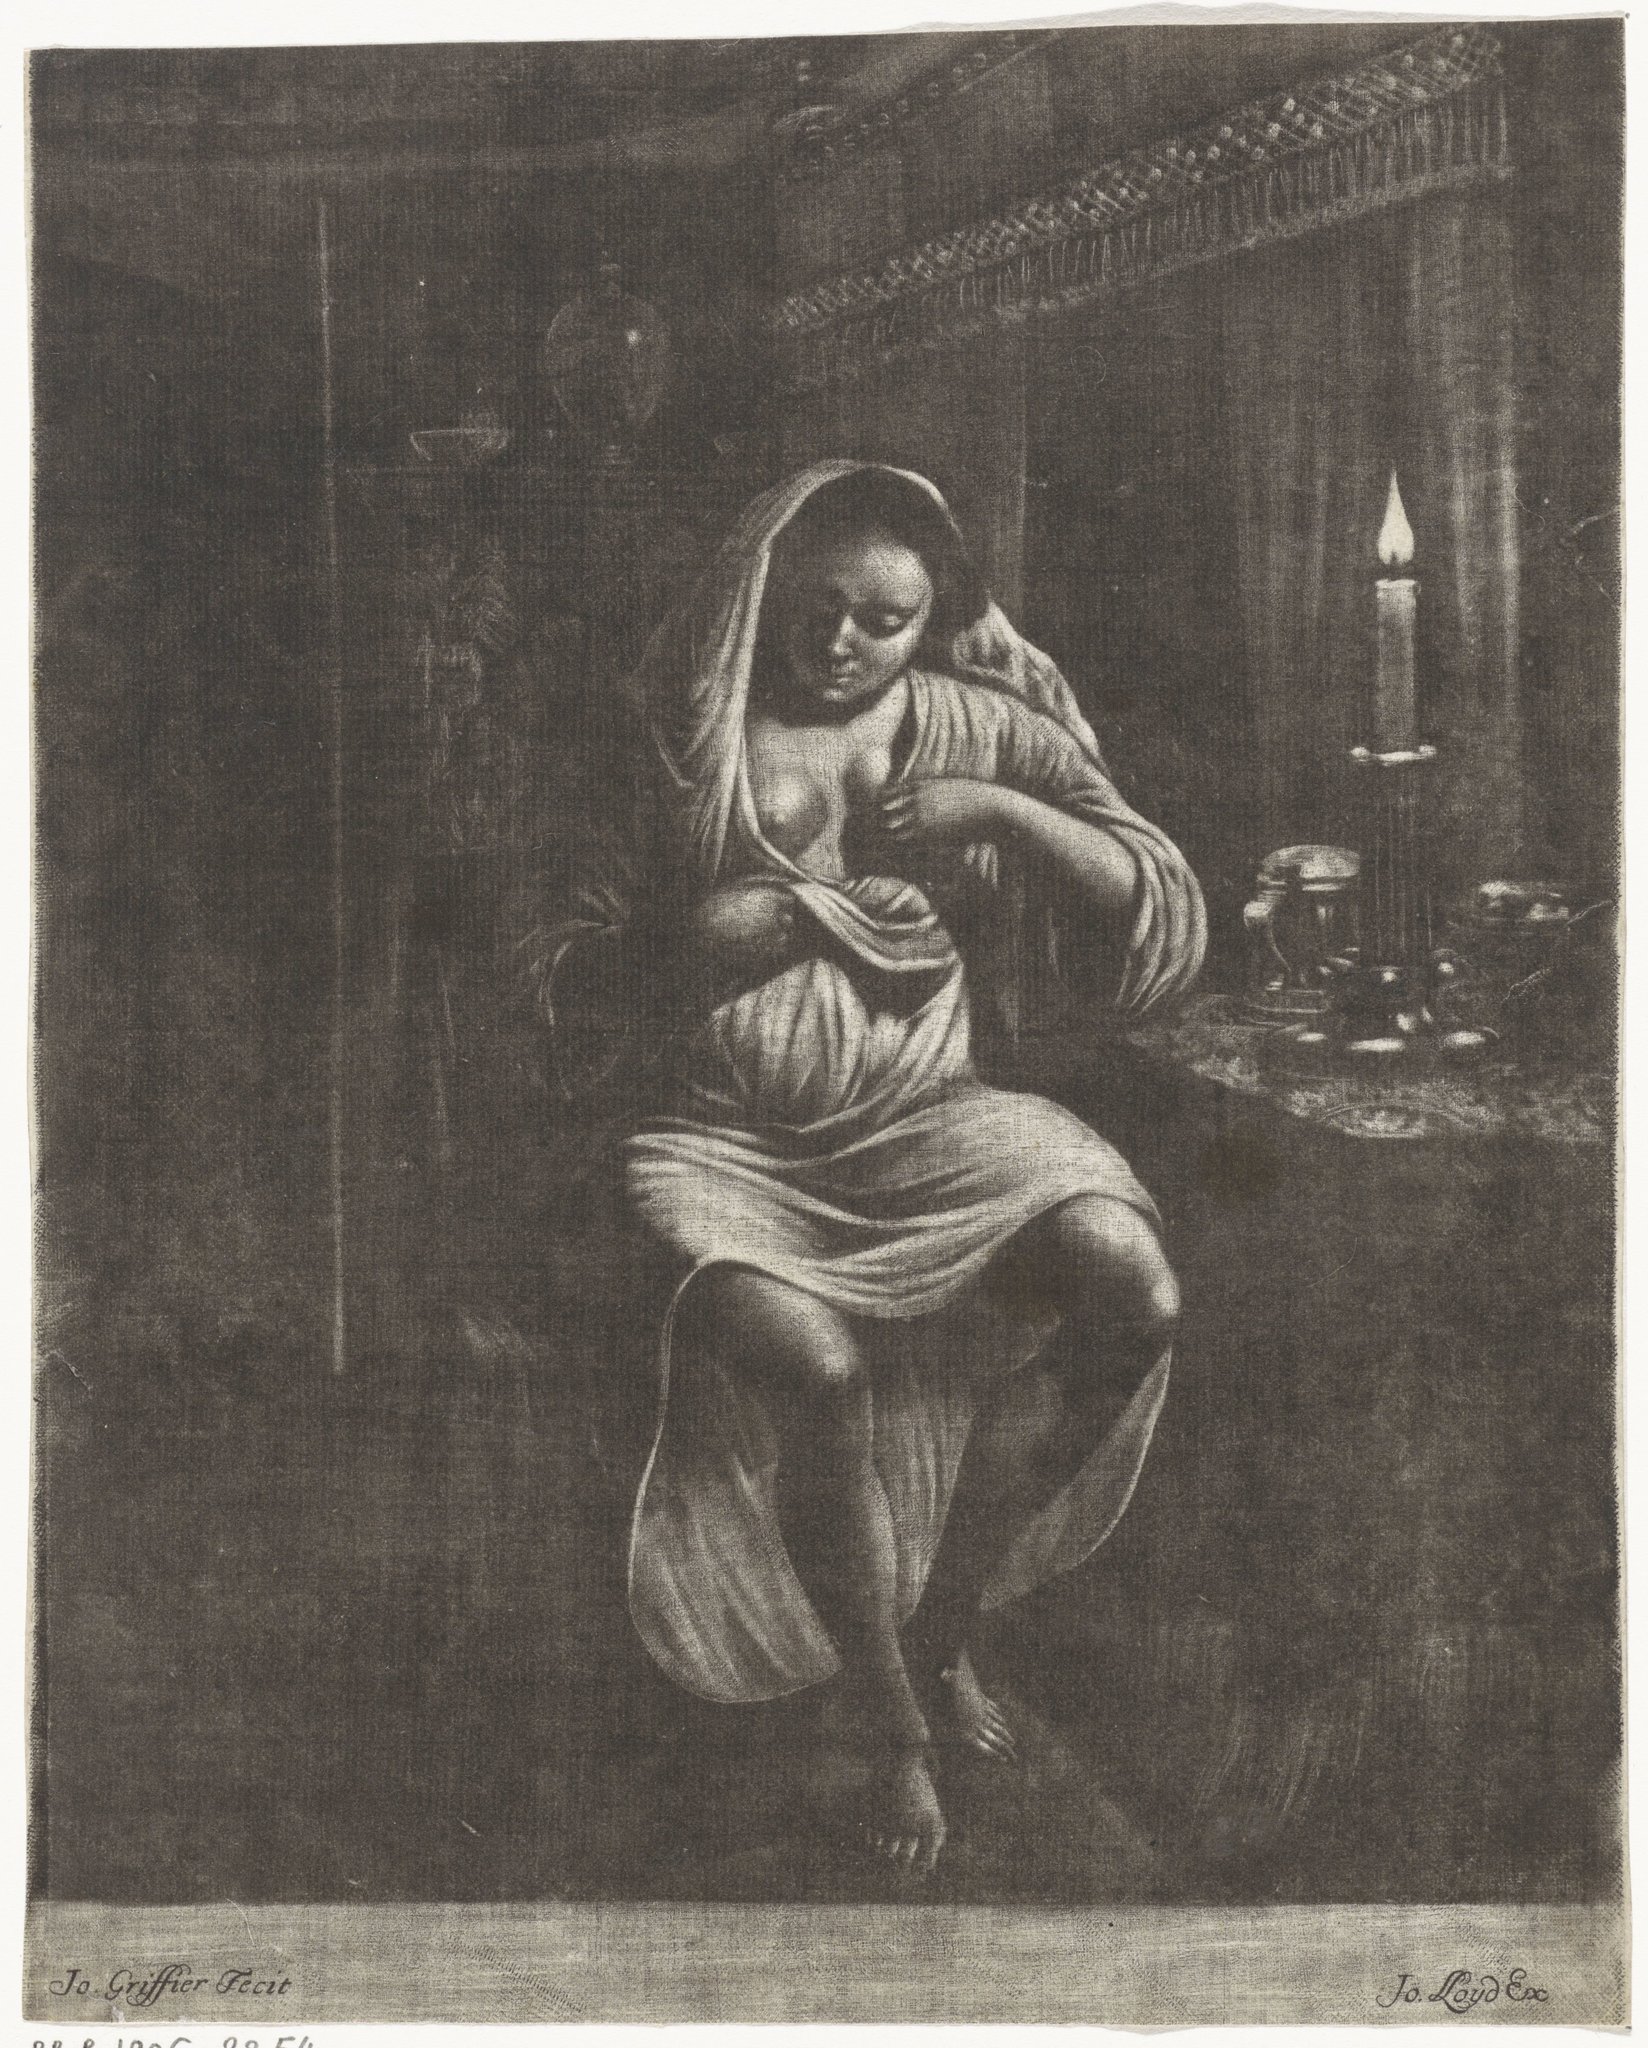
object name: print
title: Zich vlooiende vrouw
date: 1667-1718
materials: paper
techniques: engraving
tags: nightwear: night-gown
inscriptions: collector's mark: Lugt 2228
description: Bij het licht van een kaars zoekt een jonge vrouw in haar kleding naar vlooien.